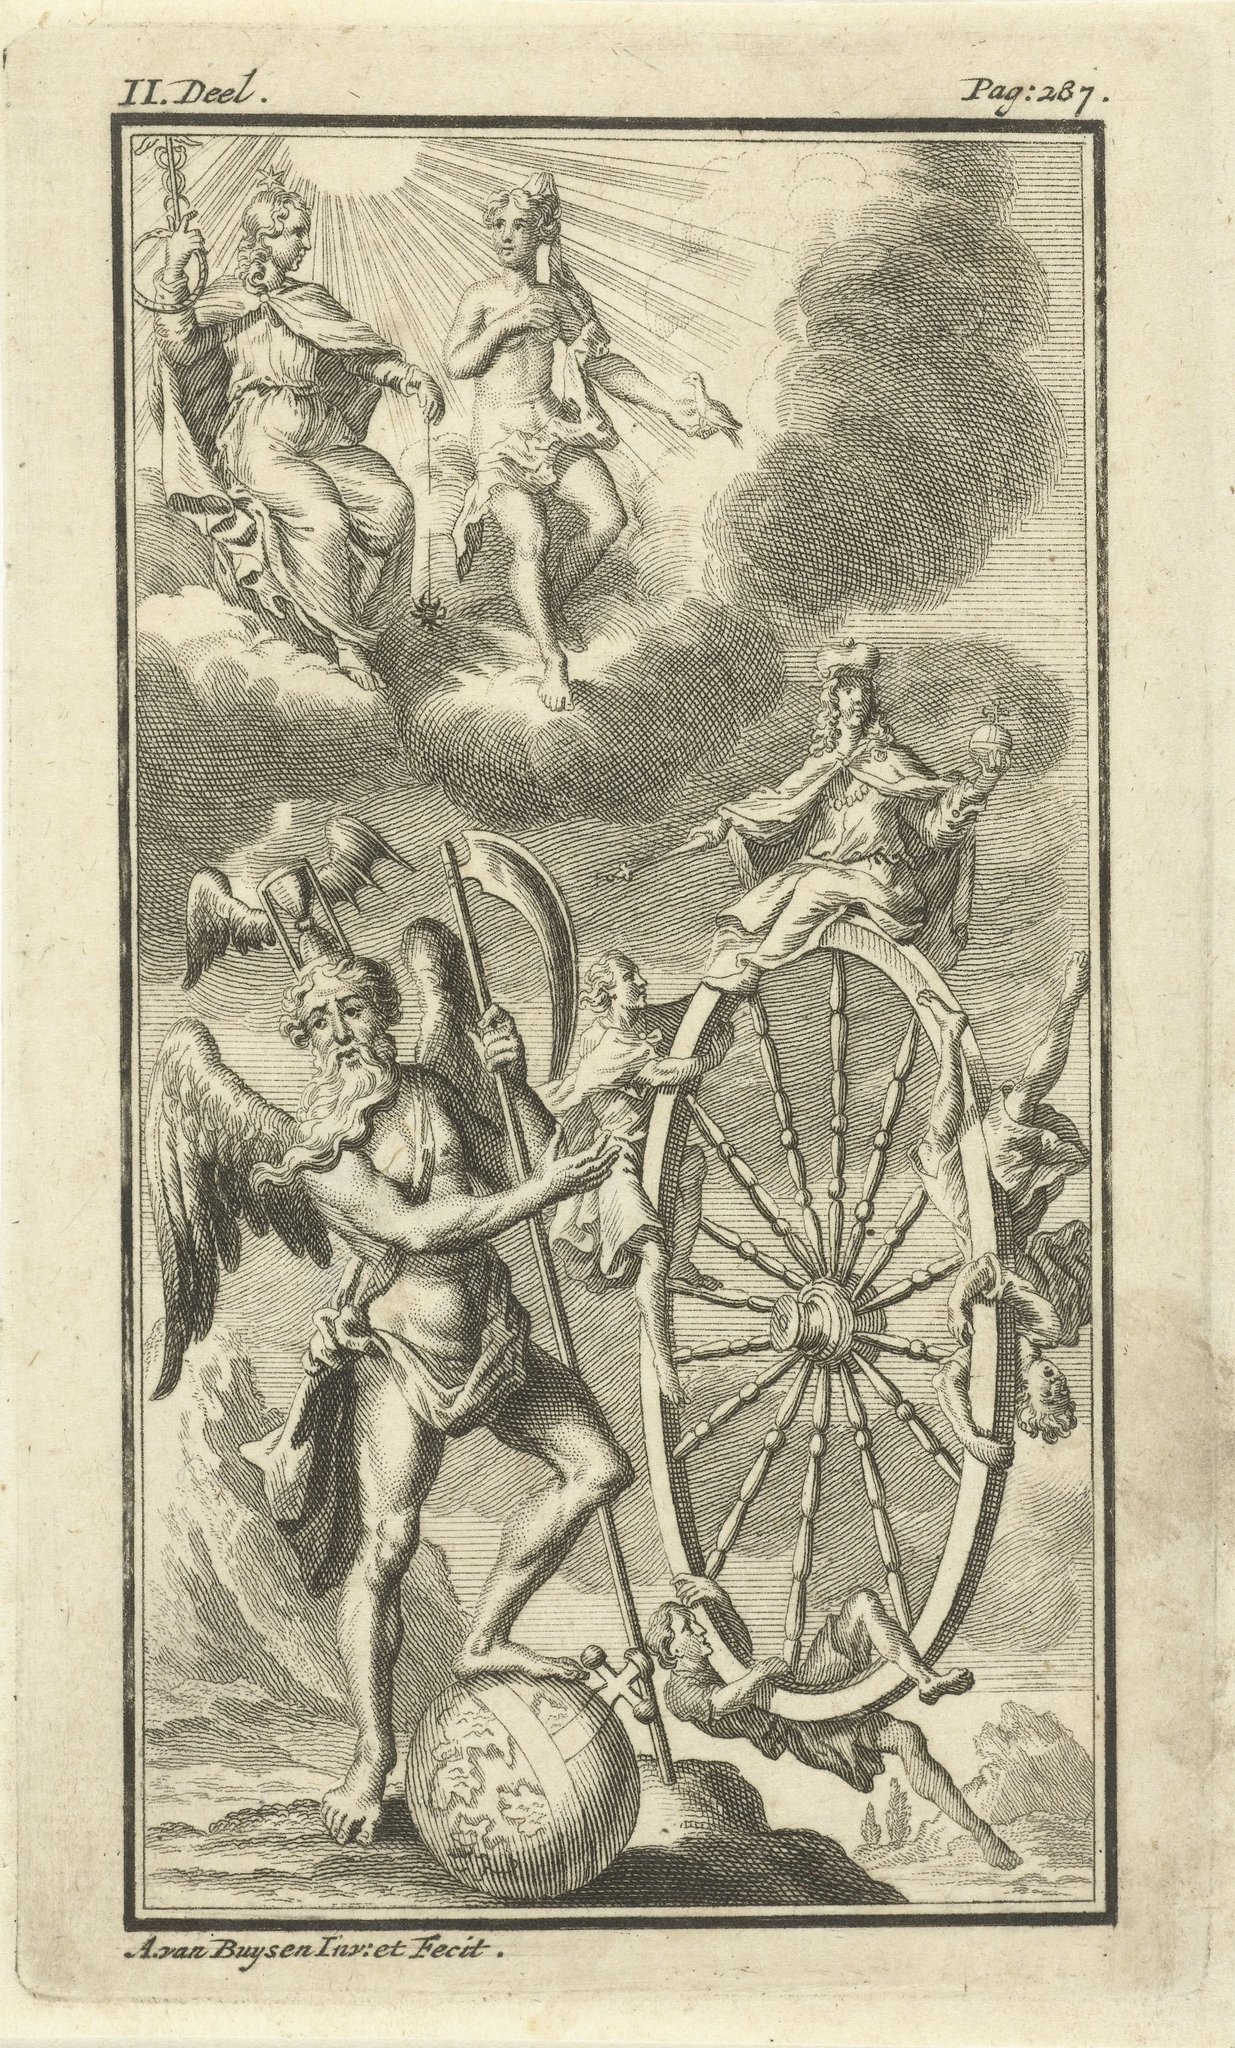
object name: book illustration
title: Vader Tijd met het Rad van Fortuin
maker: andries van buysen (sr.)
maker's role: print maker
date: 1723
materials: paper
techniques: engraving, etching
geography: amsterdam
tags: turn of fate, wheel of fortune, allegory of time and eternity, authority, power; 'dominio', 'giurisdittione' (ripa) (+ one concept conquering the other)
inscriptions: collector's mark: Lugt 2228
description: Allegorie op de vergankelijkheid van de macht. Vader Tijd, met zeis, vleugels en een zandloper op zijn hoofd, staat met zijn voet op de wereldbol en wijst naar het Rad van Fortuin. Op dit moment zit de koning boven op, maar het rad blijft draaien. Vanuit de hemel kijken twee Goden naar de gebeurtenissen op de wereld.